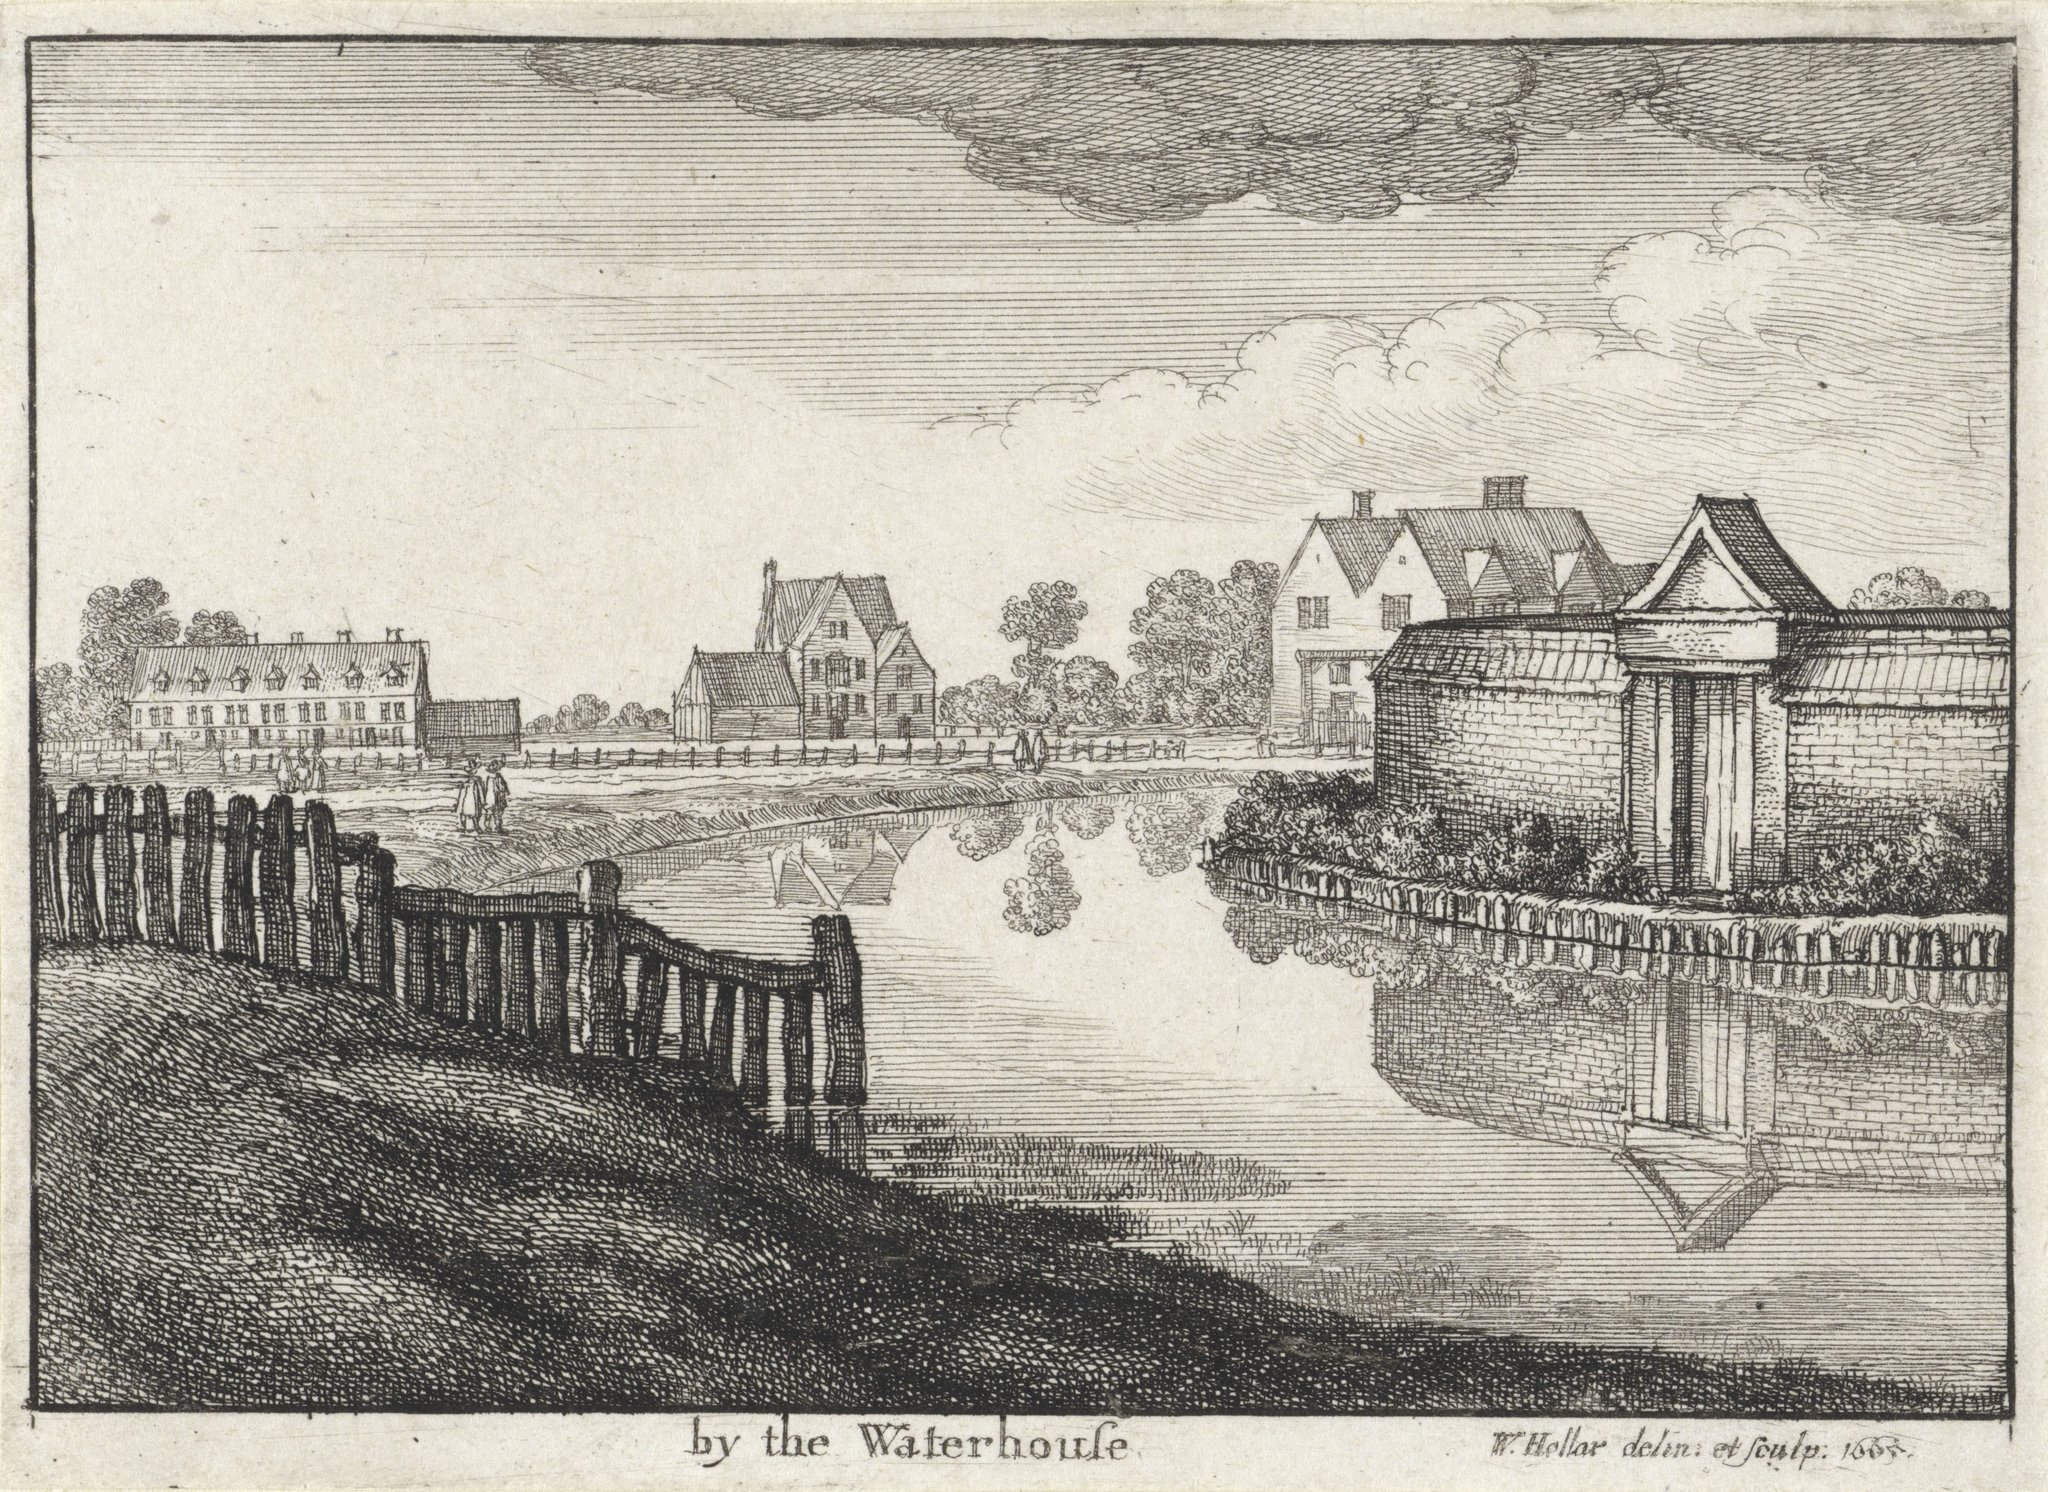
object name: print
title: Gezicht op huizen langs een rivier in de buurt van Londen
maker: wenceslaus hollar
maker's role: draughtsman, print maker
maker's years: 1607-1677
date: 1665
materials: paper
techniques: etching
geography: london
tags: river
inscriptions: collector's mark: Lugt 240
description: De prent maakt deel uit van een zesdelige serie met gezichten nabij Londen.